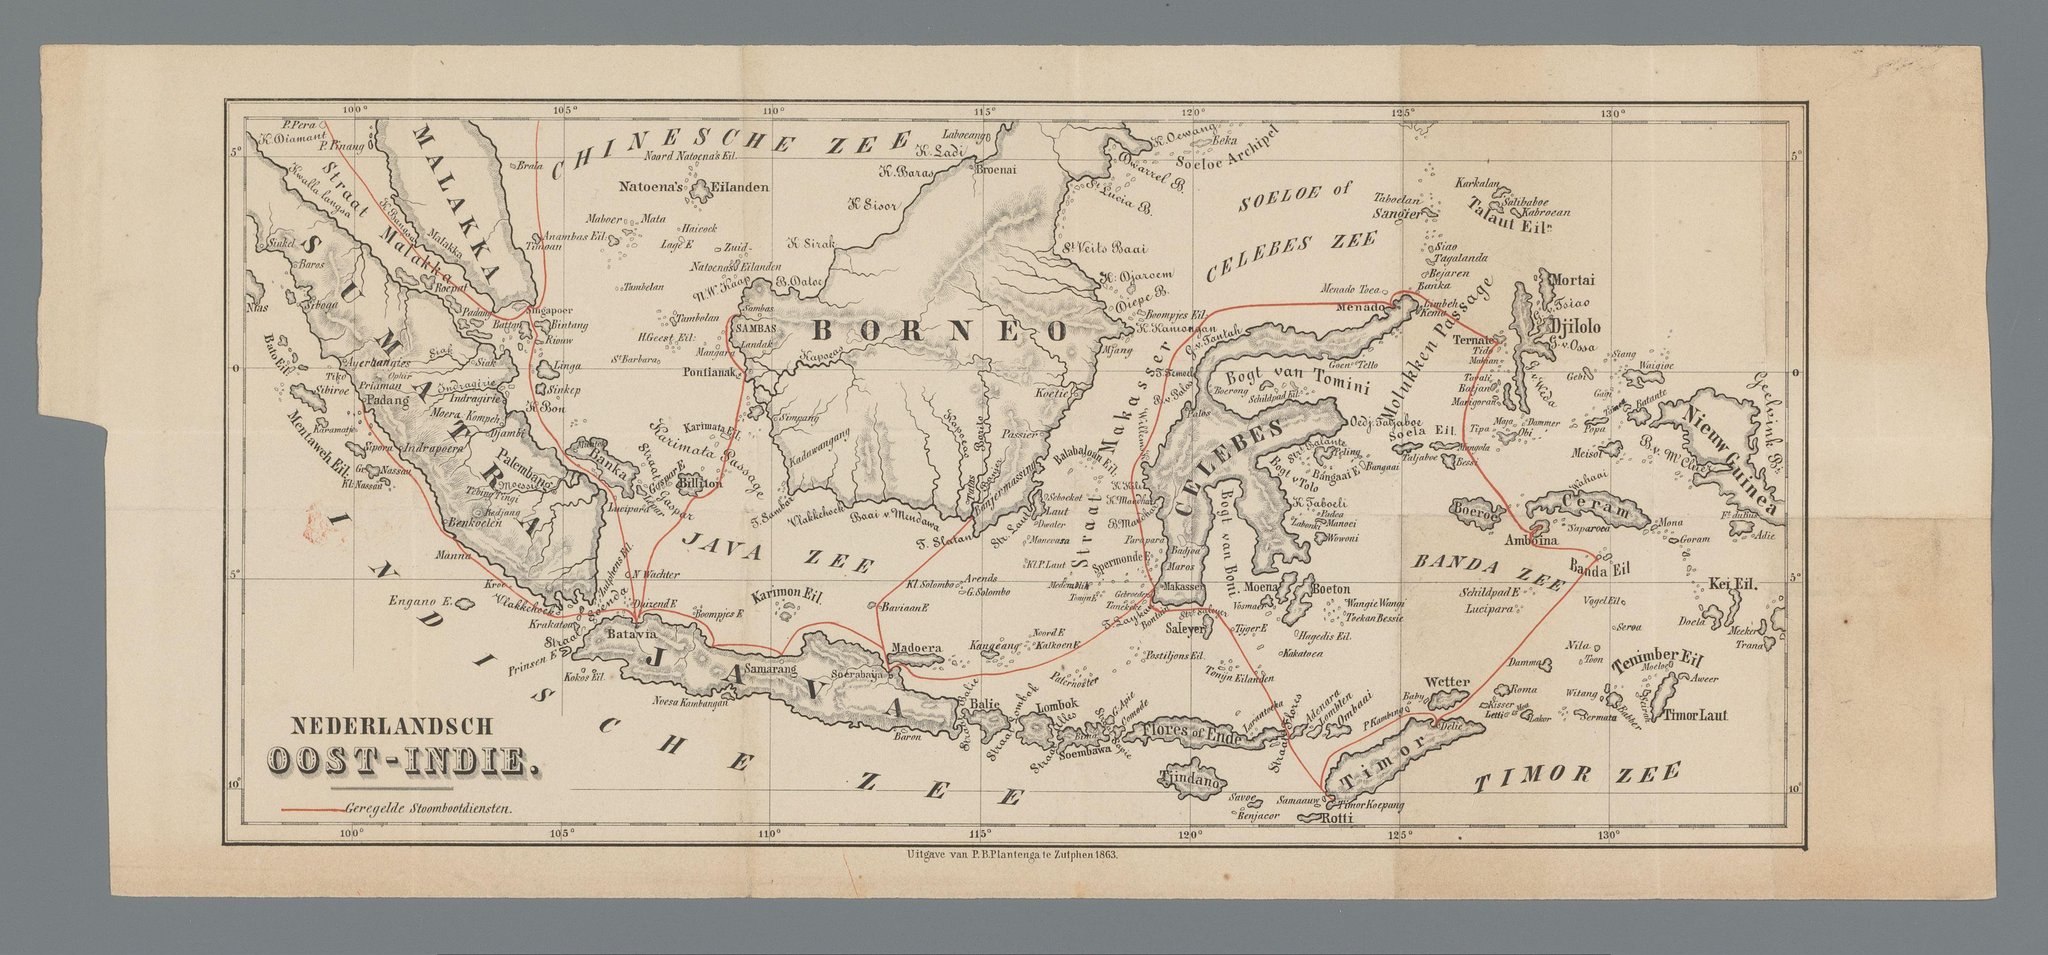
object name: map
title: Nederlandsch Oost-Indie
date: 1863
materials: ink, paper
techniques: engraving, pen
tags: maps of separate countries or regions, steamship, motorship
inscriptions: date